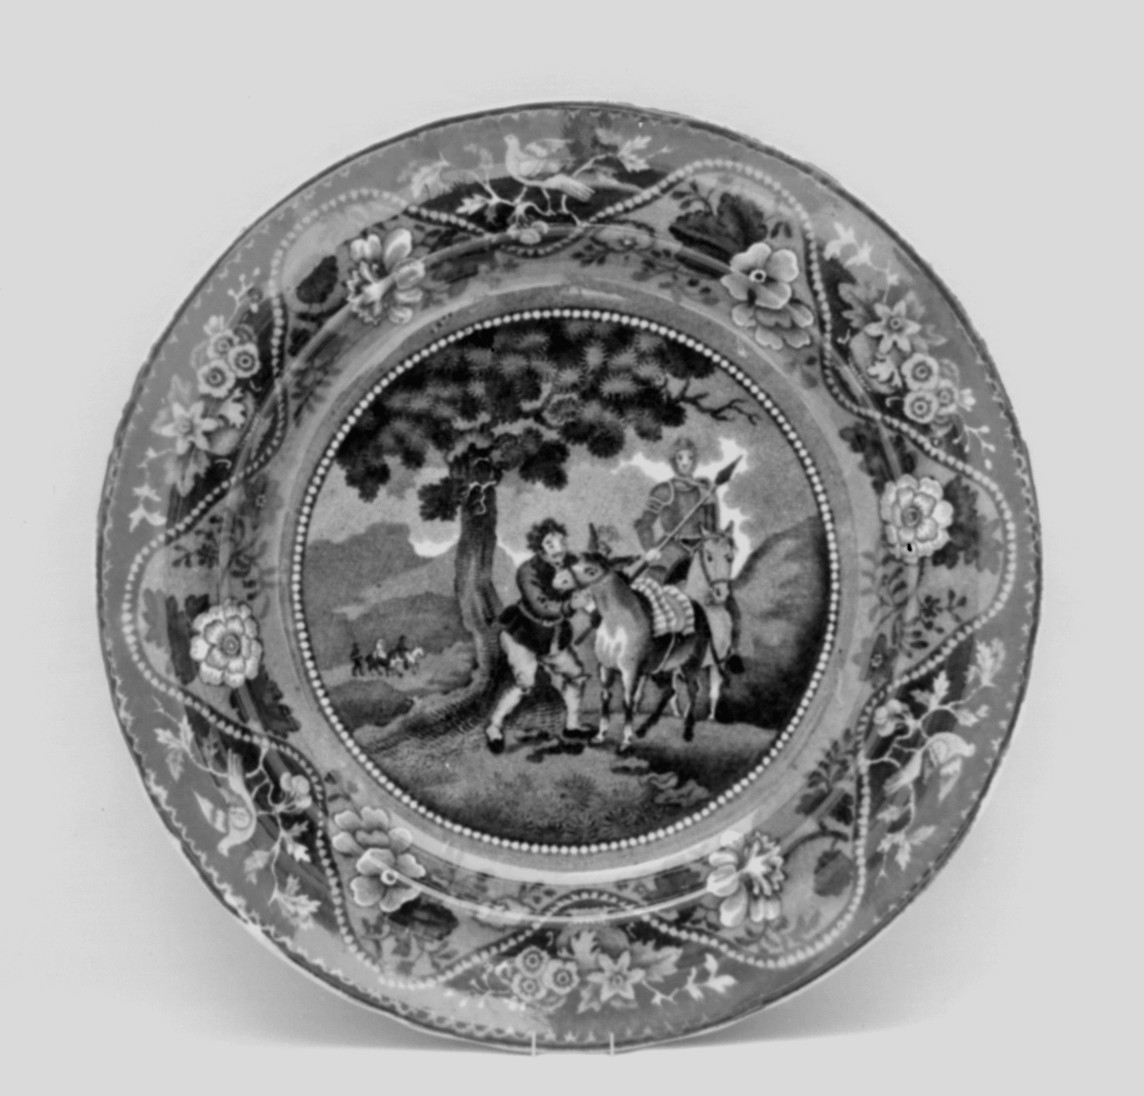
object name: plate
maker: james and ralph clews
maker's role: factory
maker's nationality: british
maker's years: 1813-1836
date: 1801-1900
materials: pottery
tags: men,horses,flowers,don quixote